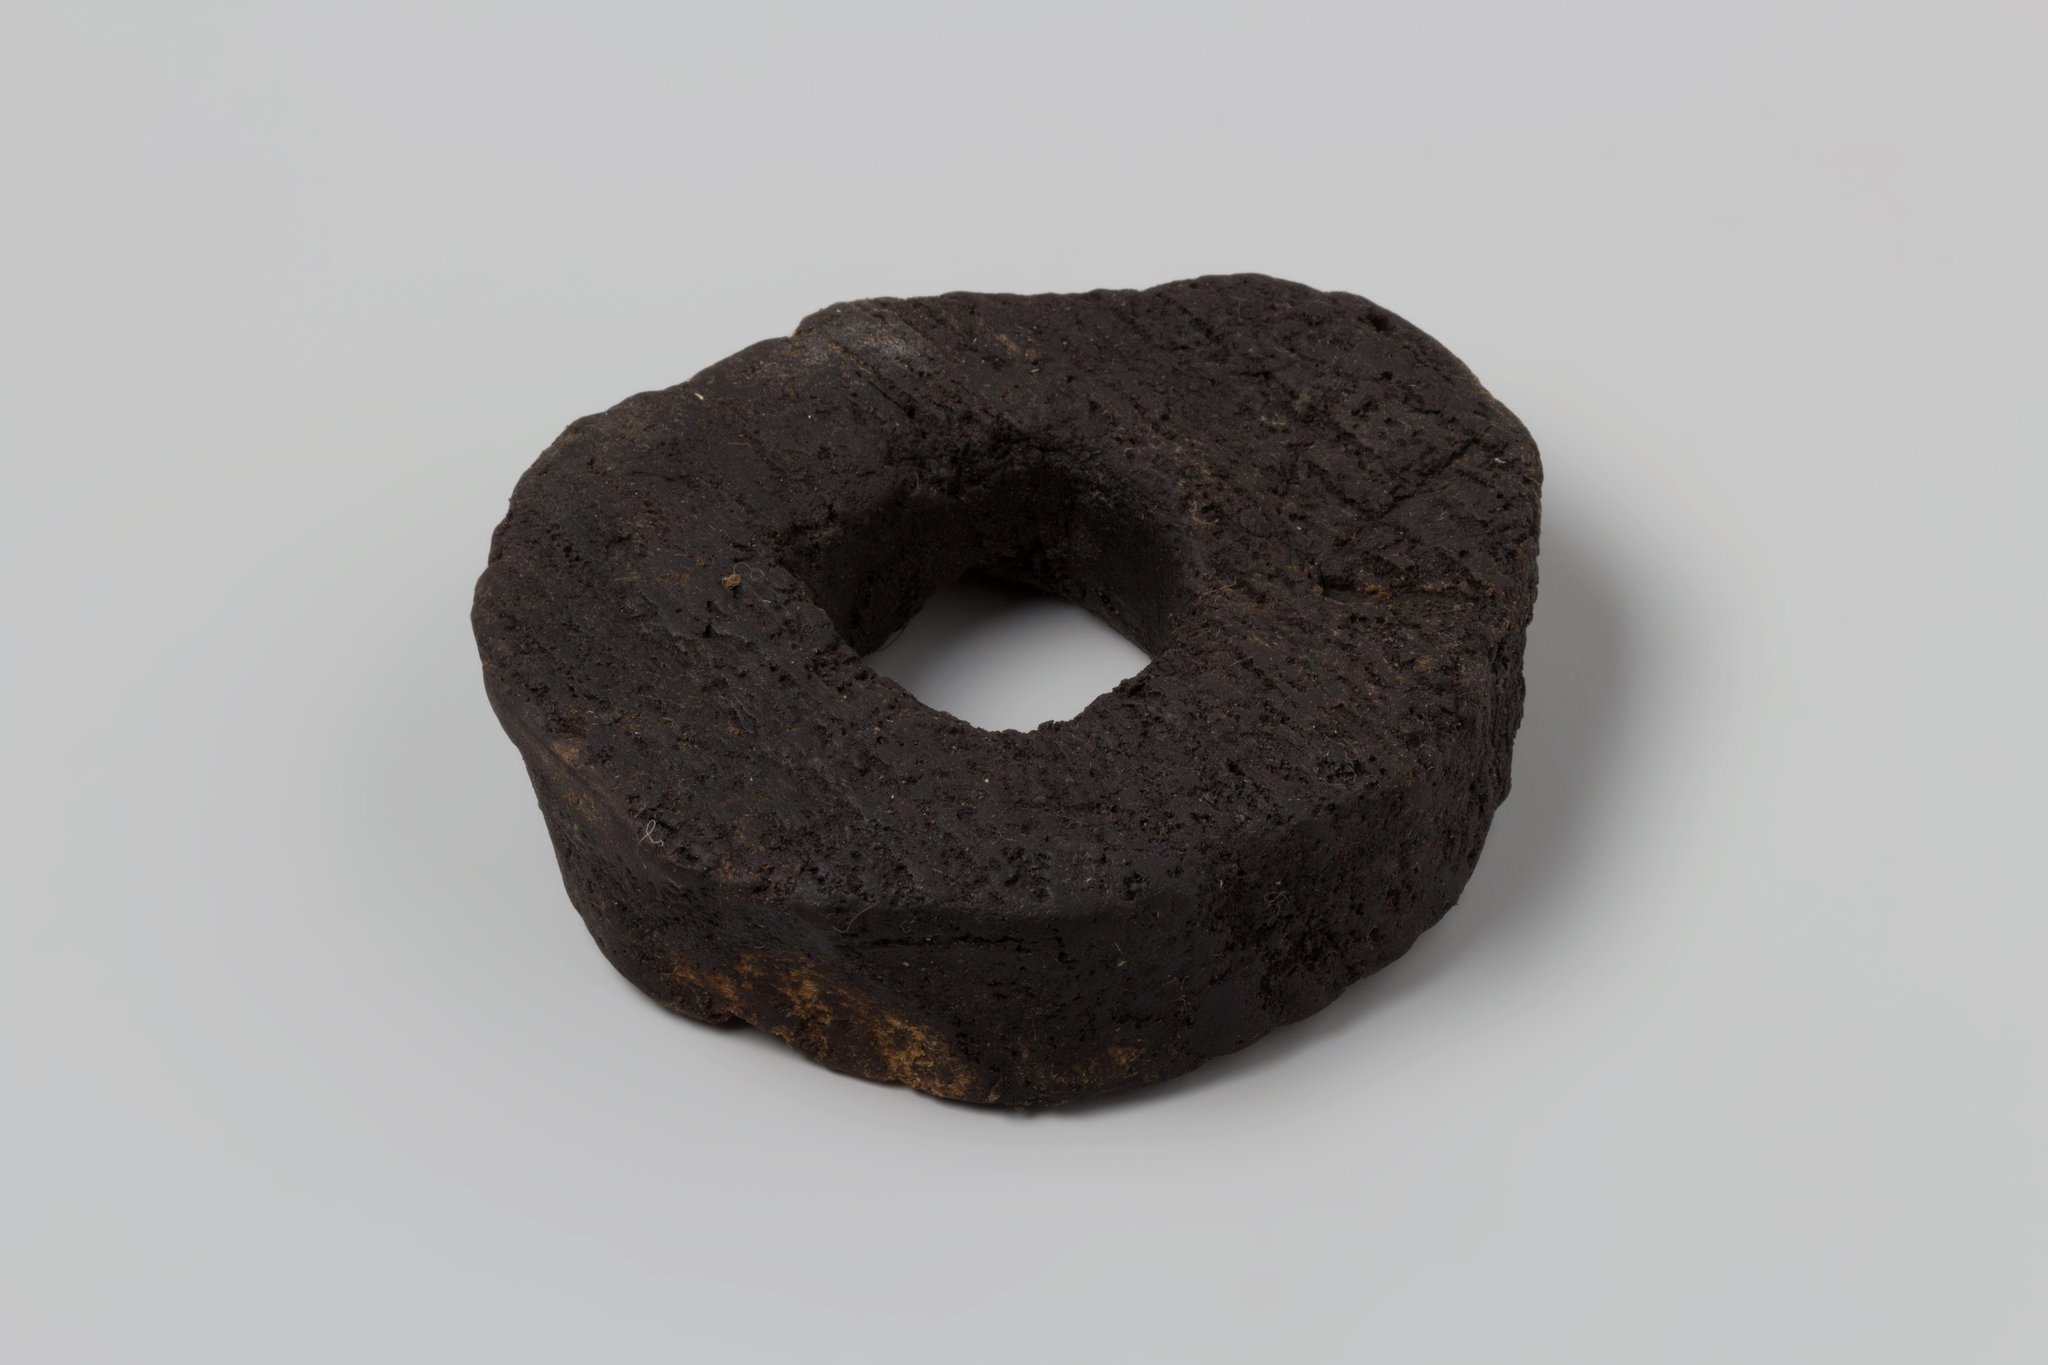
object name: disk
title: Schijf uit V.O.C.-schip de 'Witte Leeuw'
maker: Anonymous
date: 1613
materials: wood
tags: verenigde oostindische compagnie, sint-helena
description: Schijf uit V.O.C.-schip de 'Witte Leeuw'.